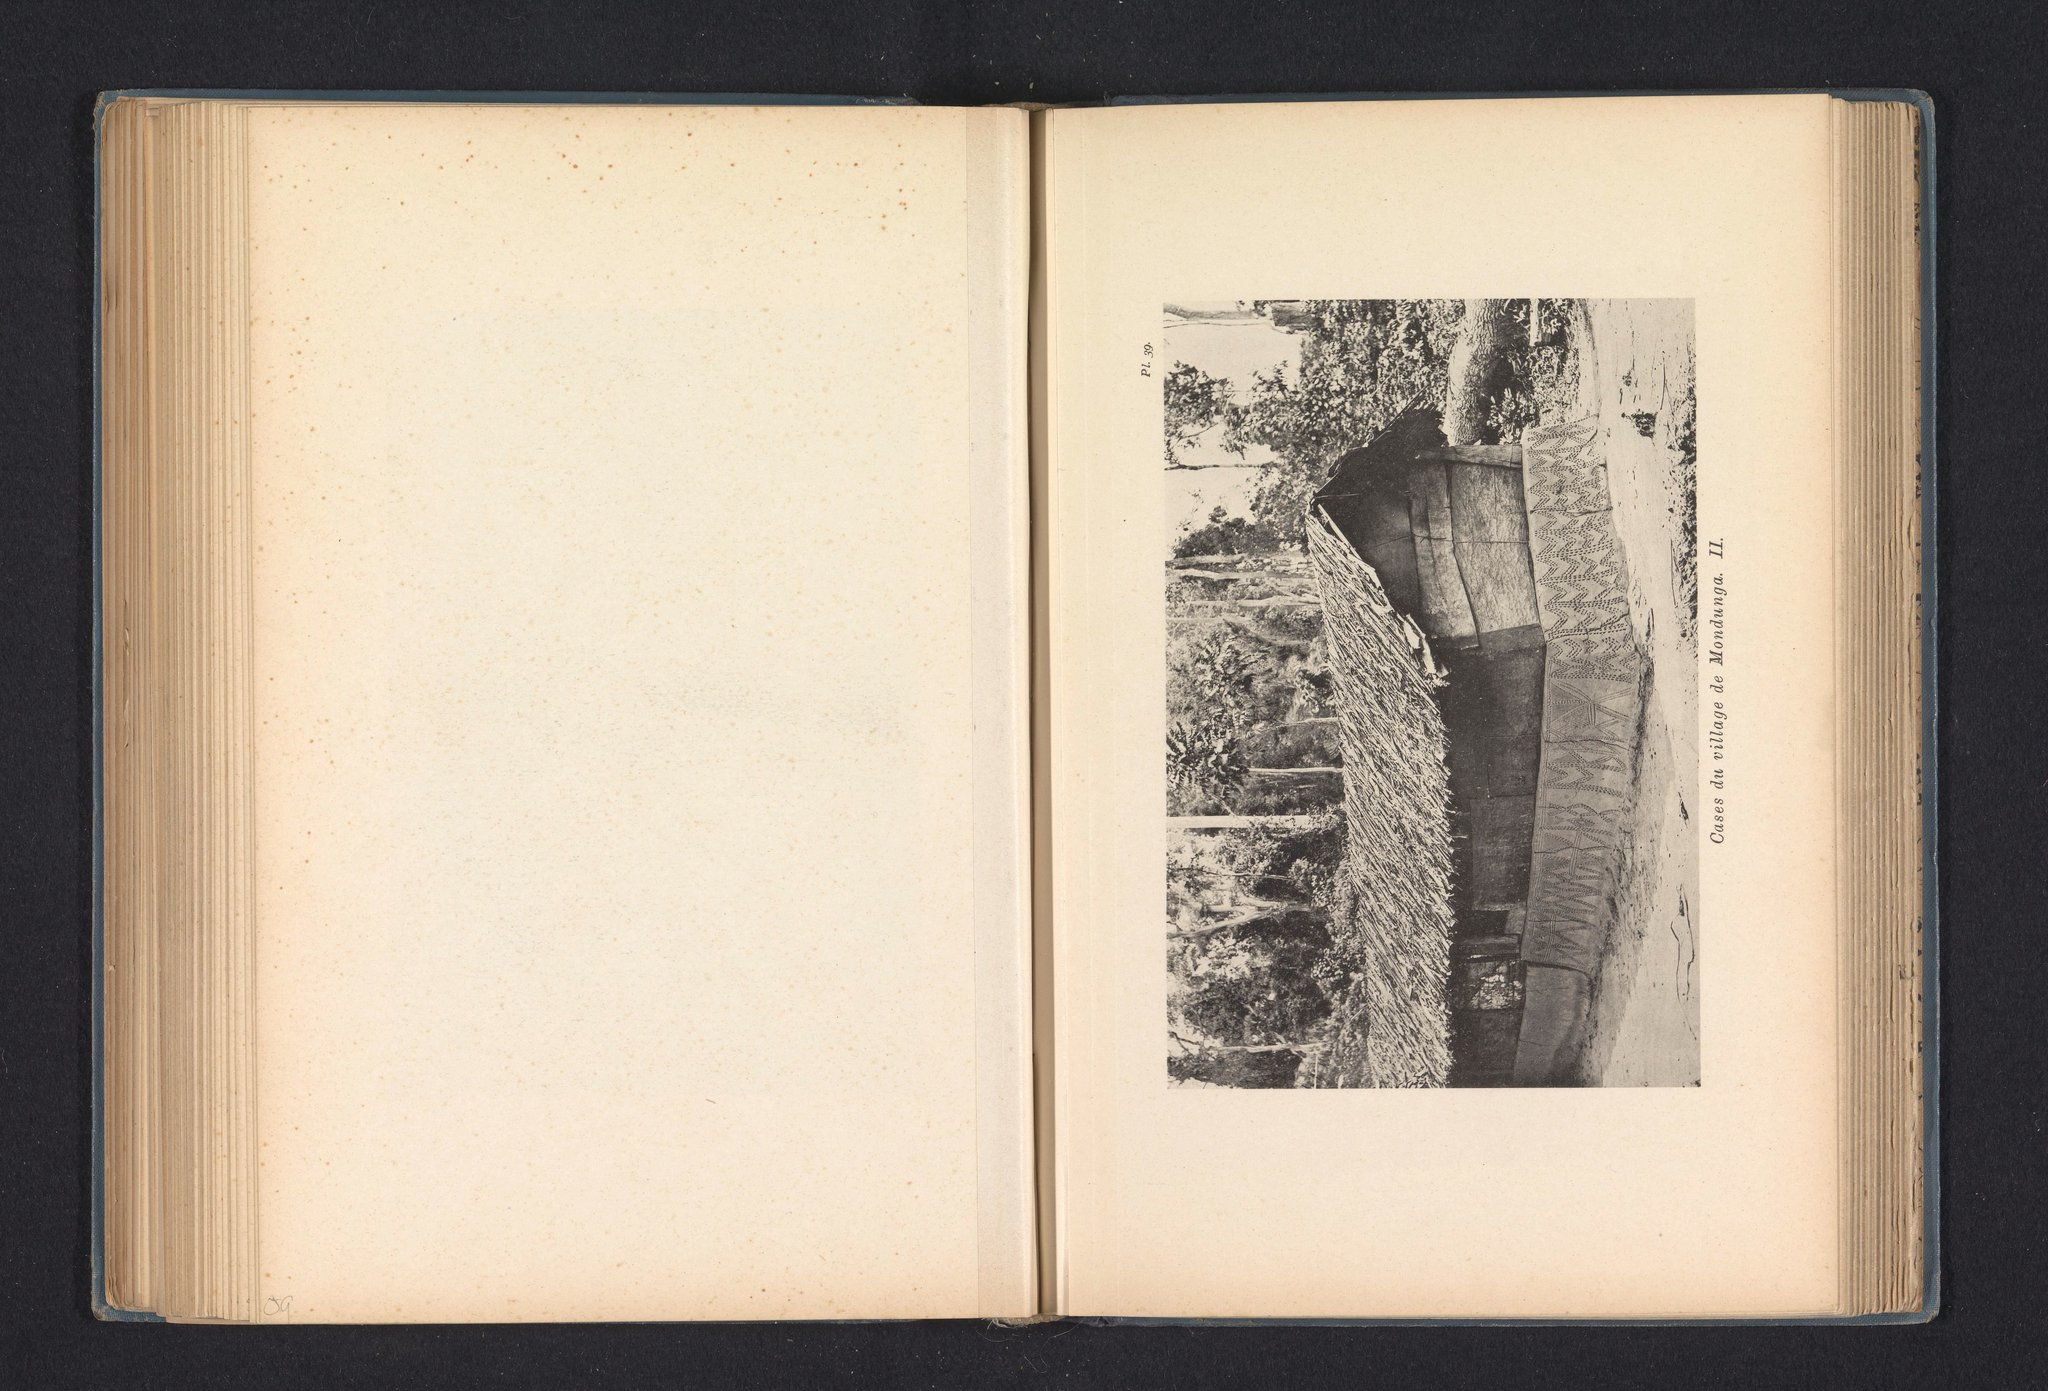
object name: photomechanical print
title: Cases du village de Mondunga II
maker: franz thonner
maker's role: botanicus, ontdekkingsreiziger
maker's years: 1863-1928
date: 1896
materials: paper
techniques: photograph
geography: dresden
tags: housing, façade (of house or building)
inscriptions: number: ‘Pl. 39.’